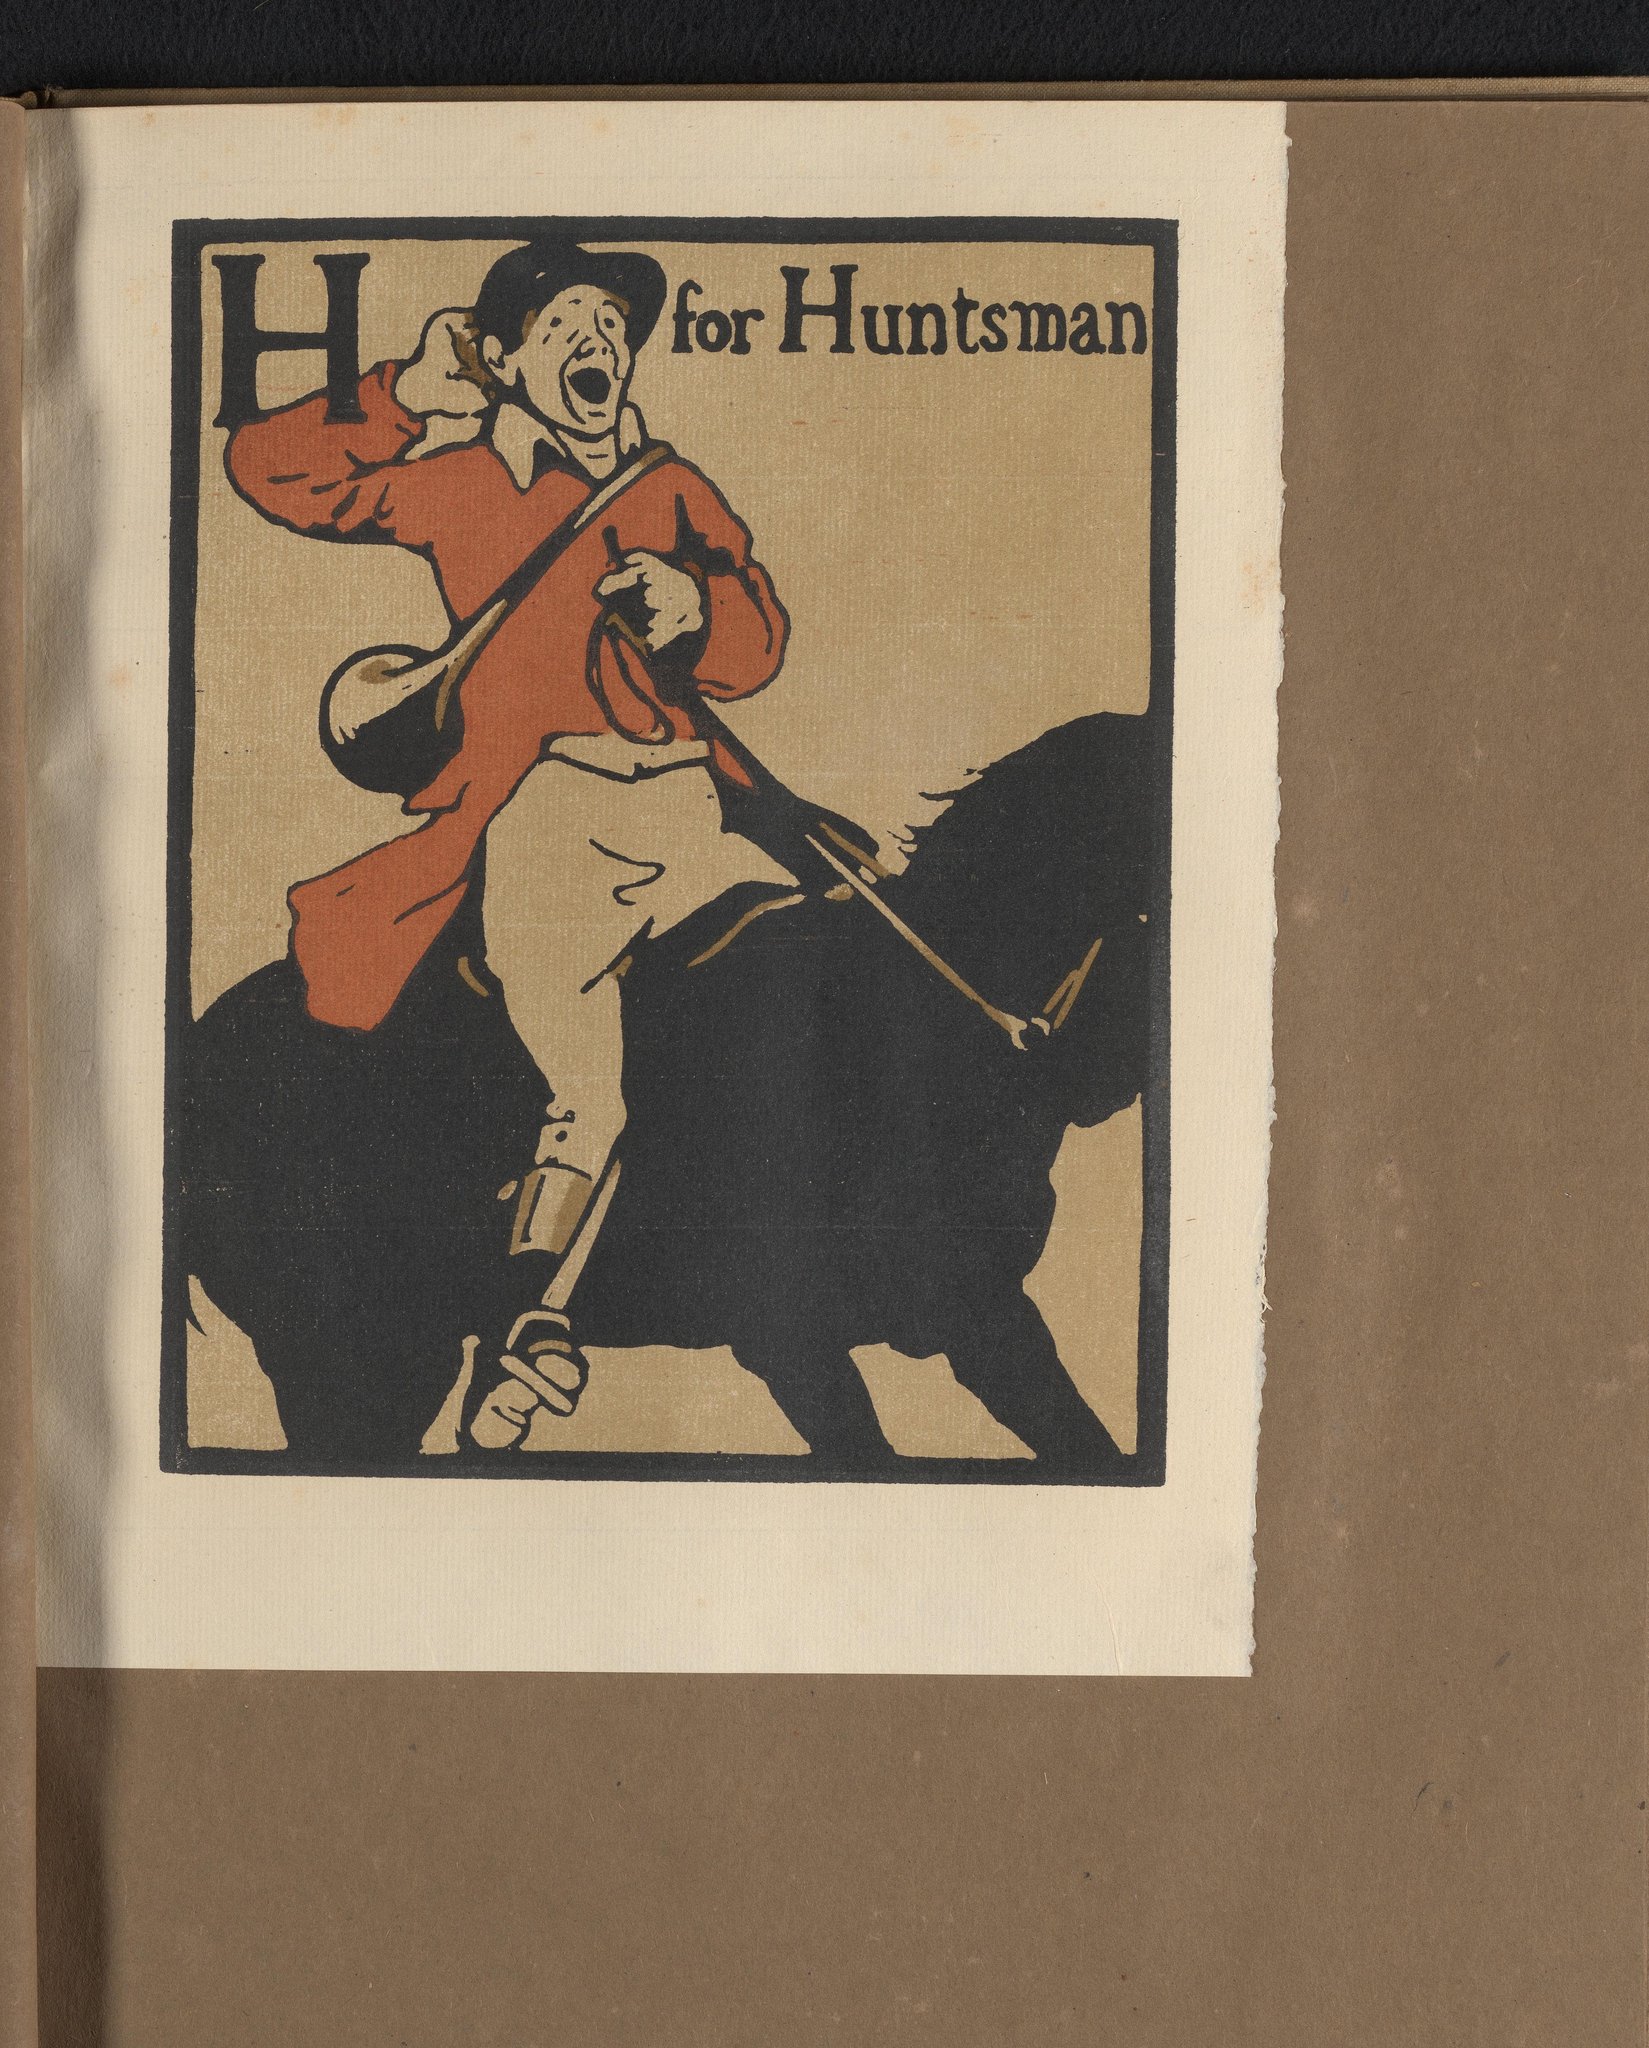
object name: page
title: An Alphabet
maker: william heinemann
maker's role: publisher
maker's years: 1863-1920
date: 1898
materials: paper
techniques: lithograph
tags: hunter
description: De serie met lithografieën is gemaakt naar ontwerpen van houtsneden door William Nicholson.